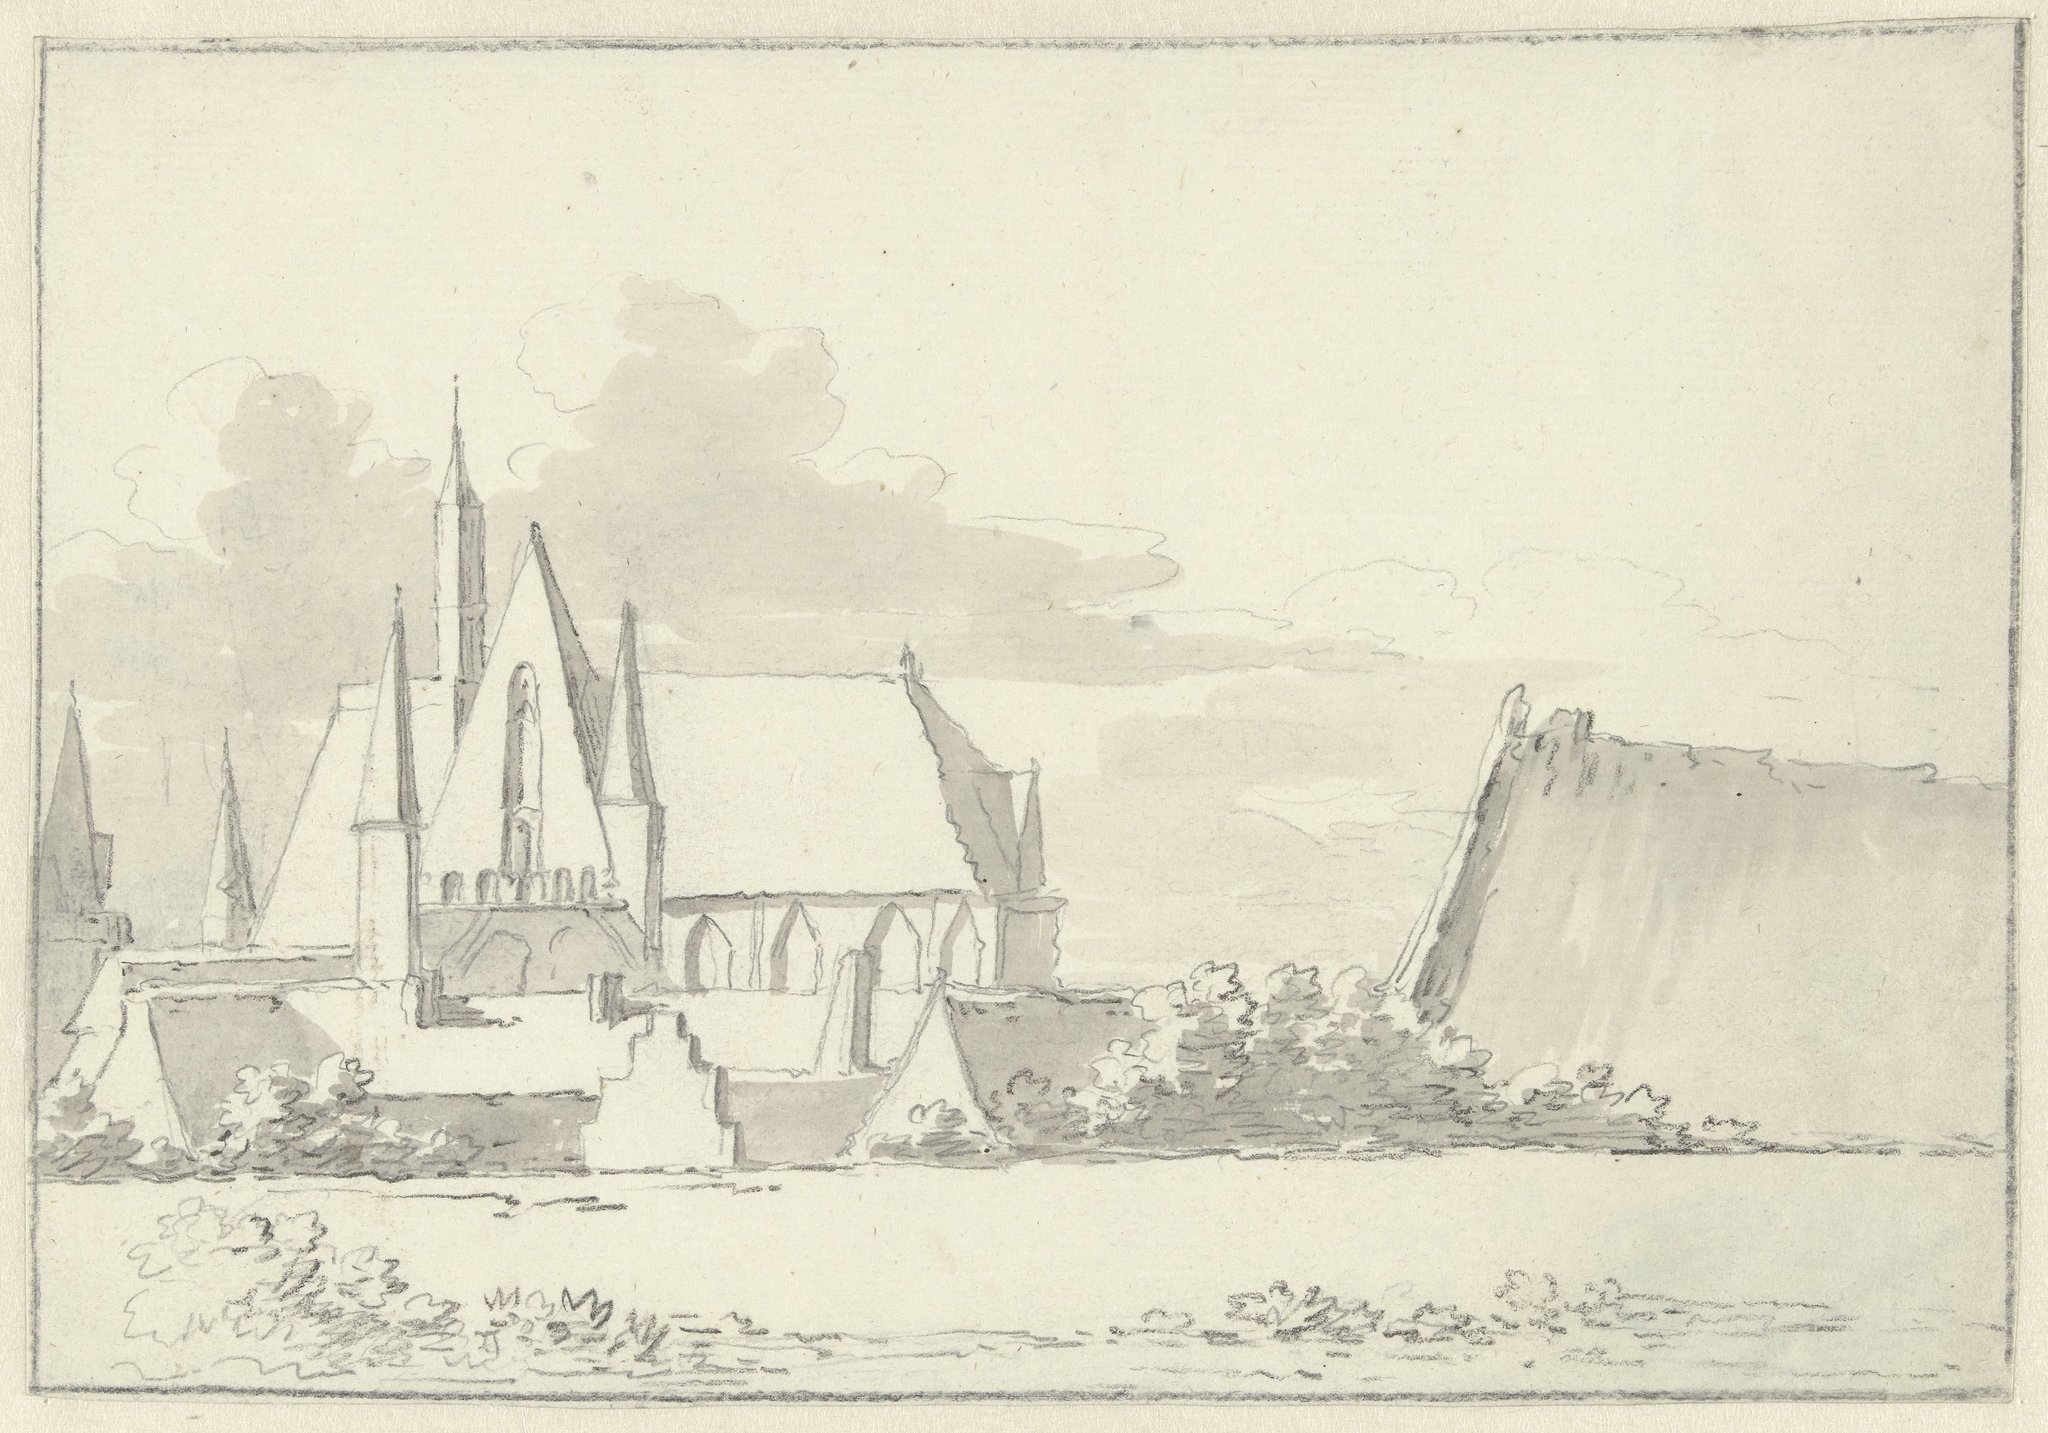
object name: drawing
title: Gezicht op een kerk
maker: Anonymous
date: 1700-1800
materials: chalk, paper, pencil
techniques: brush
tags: church (exterior)